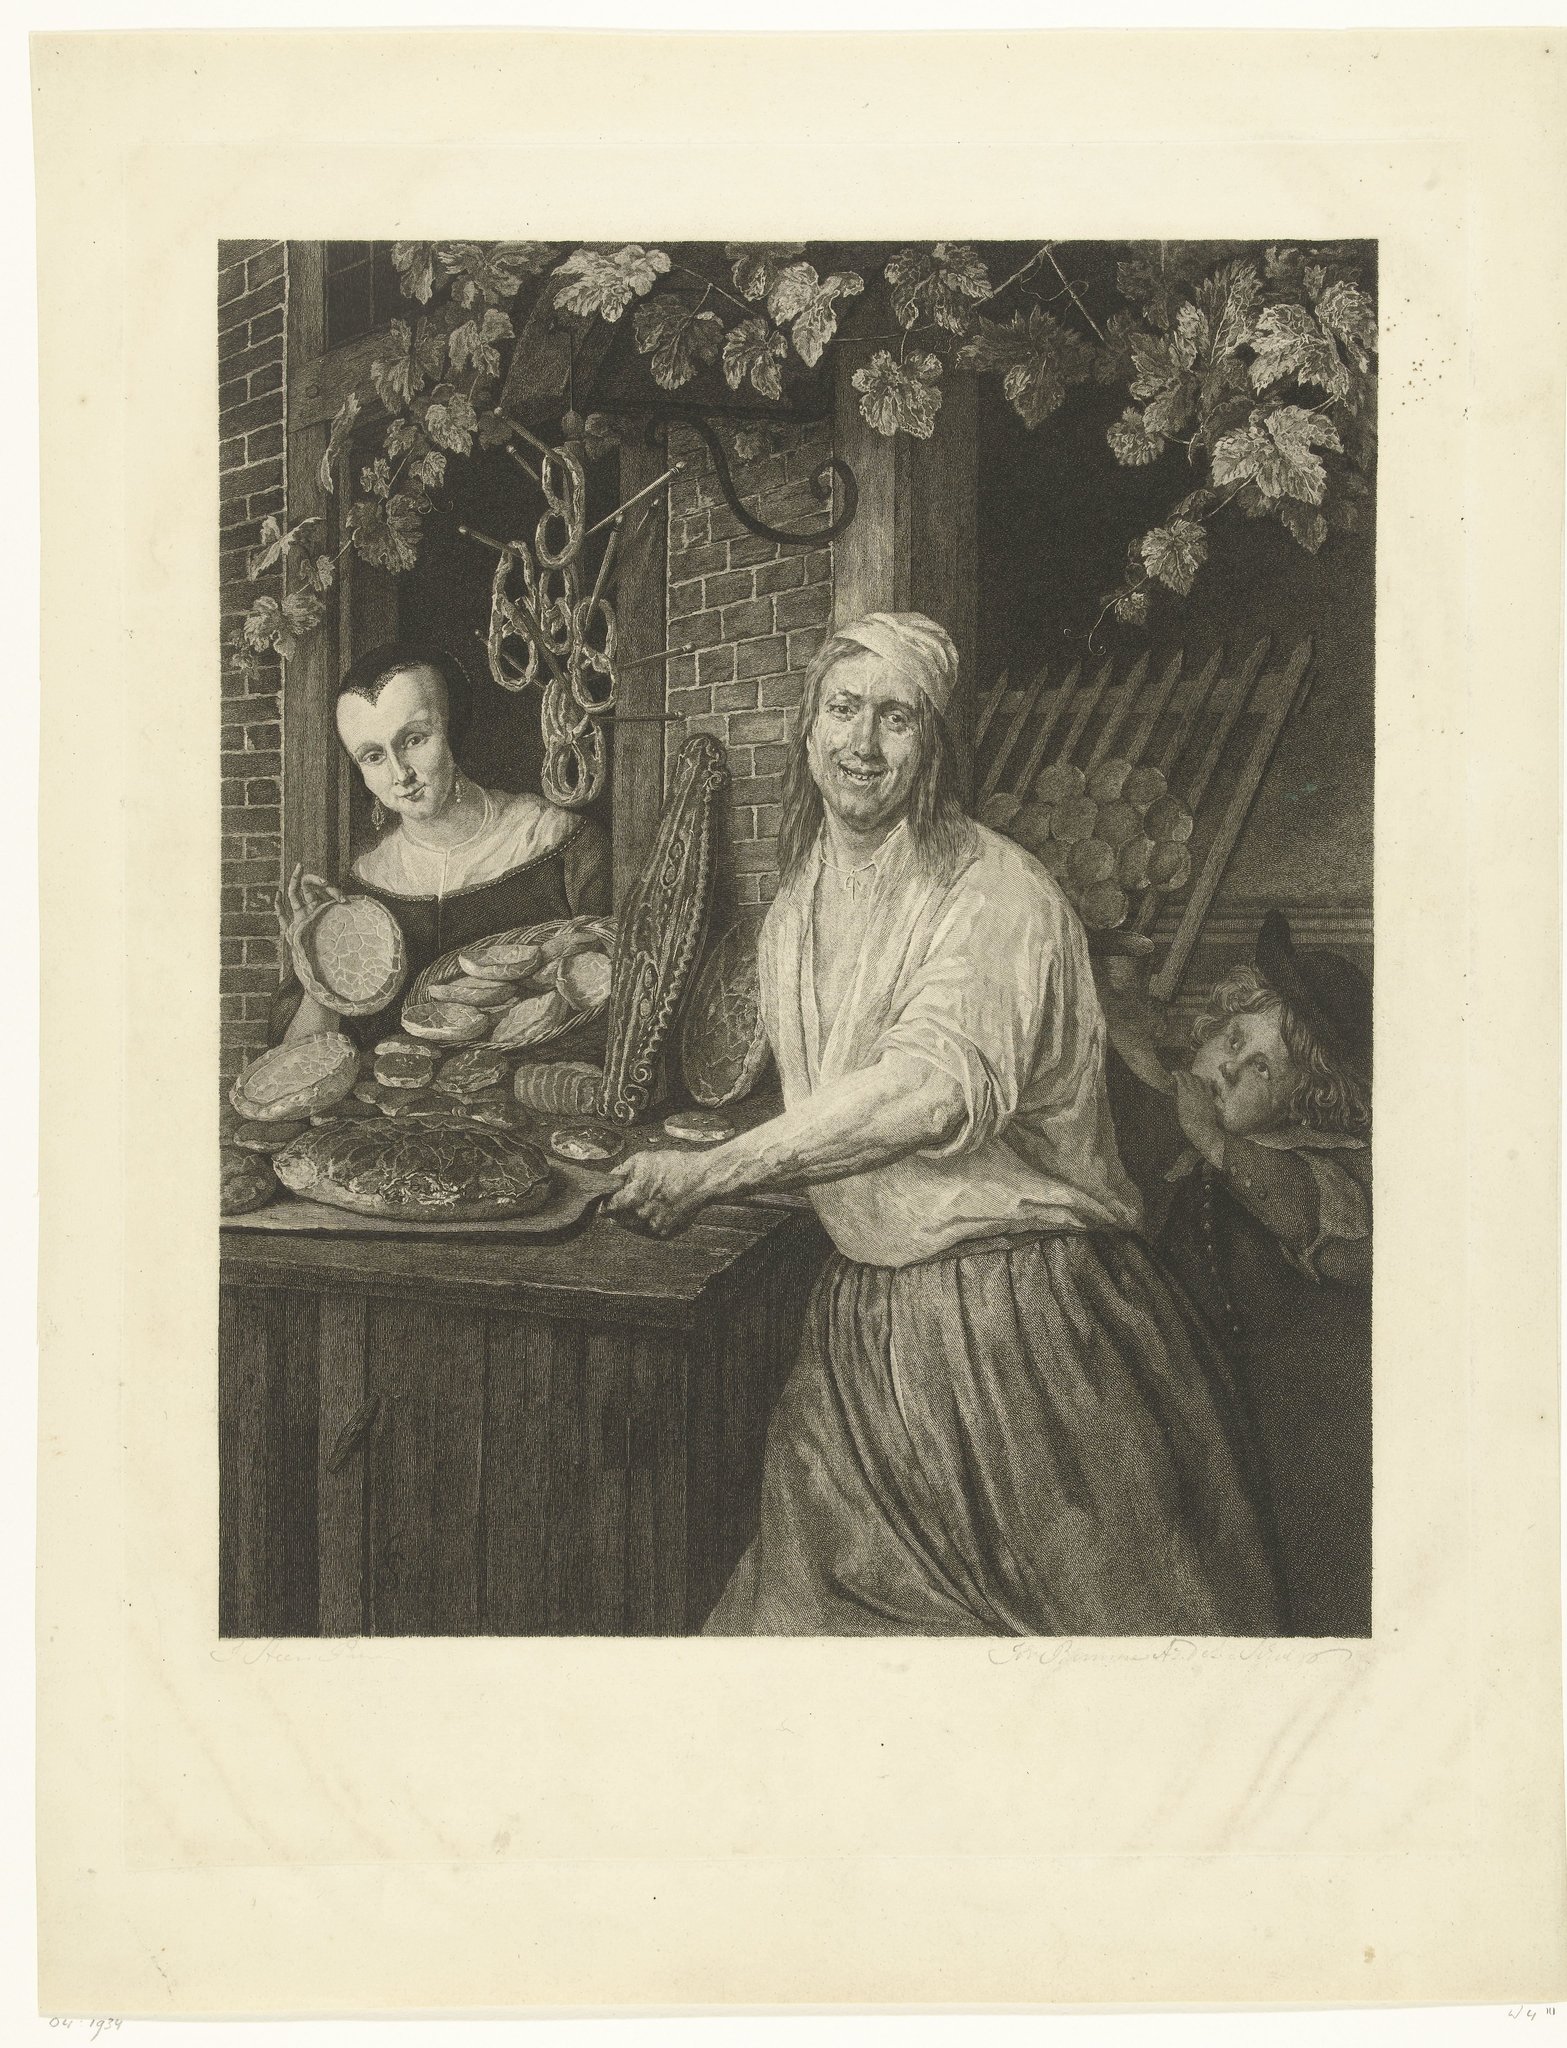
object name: print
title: Bakkersechtpaar Arent Oostwaard en Catharina Keizerswaard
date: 1800-1841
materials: paper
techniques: etching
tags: historical persons - bb - woman, historical persons, bread, loaf, hornblowing baker (+ variant), baker, baker (+ outdoors; in the open air), leiden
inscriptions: collector's mark: Lugt 2228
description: Portret van het Leidse bakkersechtpaar Arent Oostwaard (Arend Oostwaert) en Catharina Keizerswaard (Catharina Keyzerswaert) met allerlei verschillende soorten vers gebakken brood (broodjes, krakelingen, kadetten, duivekater) voor de bakkerij. In de deur van de bakkerij blaast een jongetje op een hoorn, om mensen te laten weten dat het brood klaar is. Volgens een opschrift op de achterzijde van het schilderij van Jan Steen gaat het hier om het zoontje van de schilder, Thaddeus, op 7-jarige leeftijd. Boven de deur groeien wijnranken.